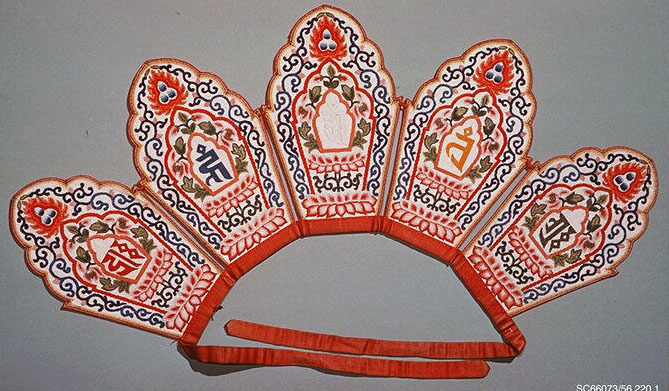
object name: headdress, lamaist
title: Lamaist Headdress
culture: chinese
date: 1801-1900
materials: silk